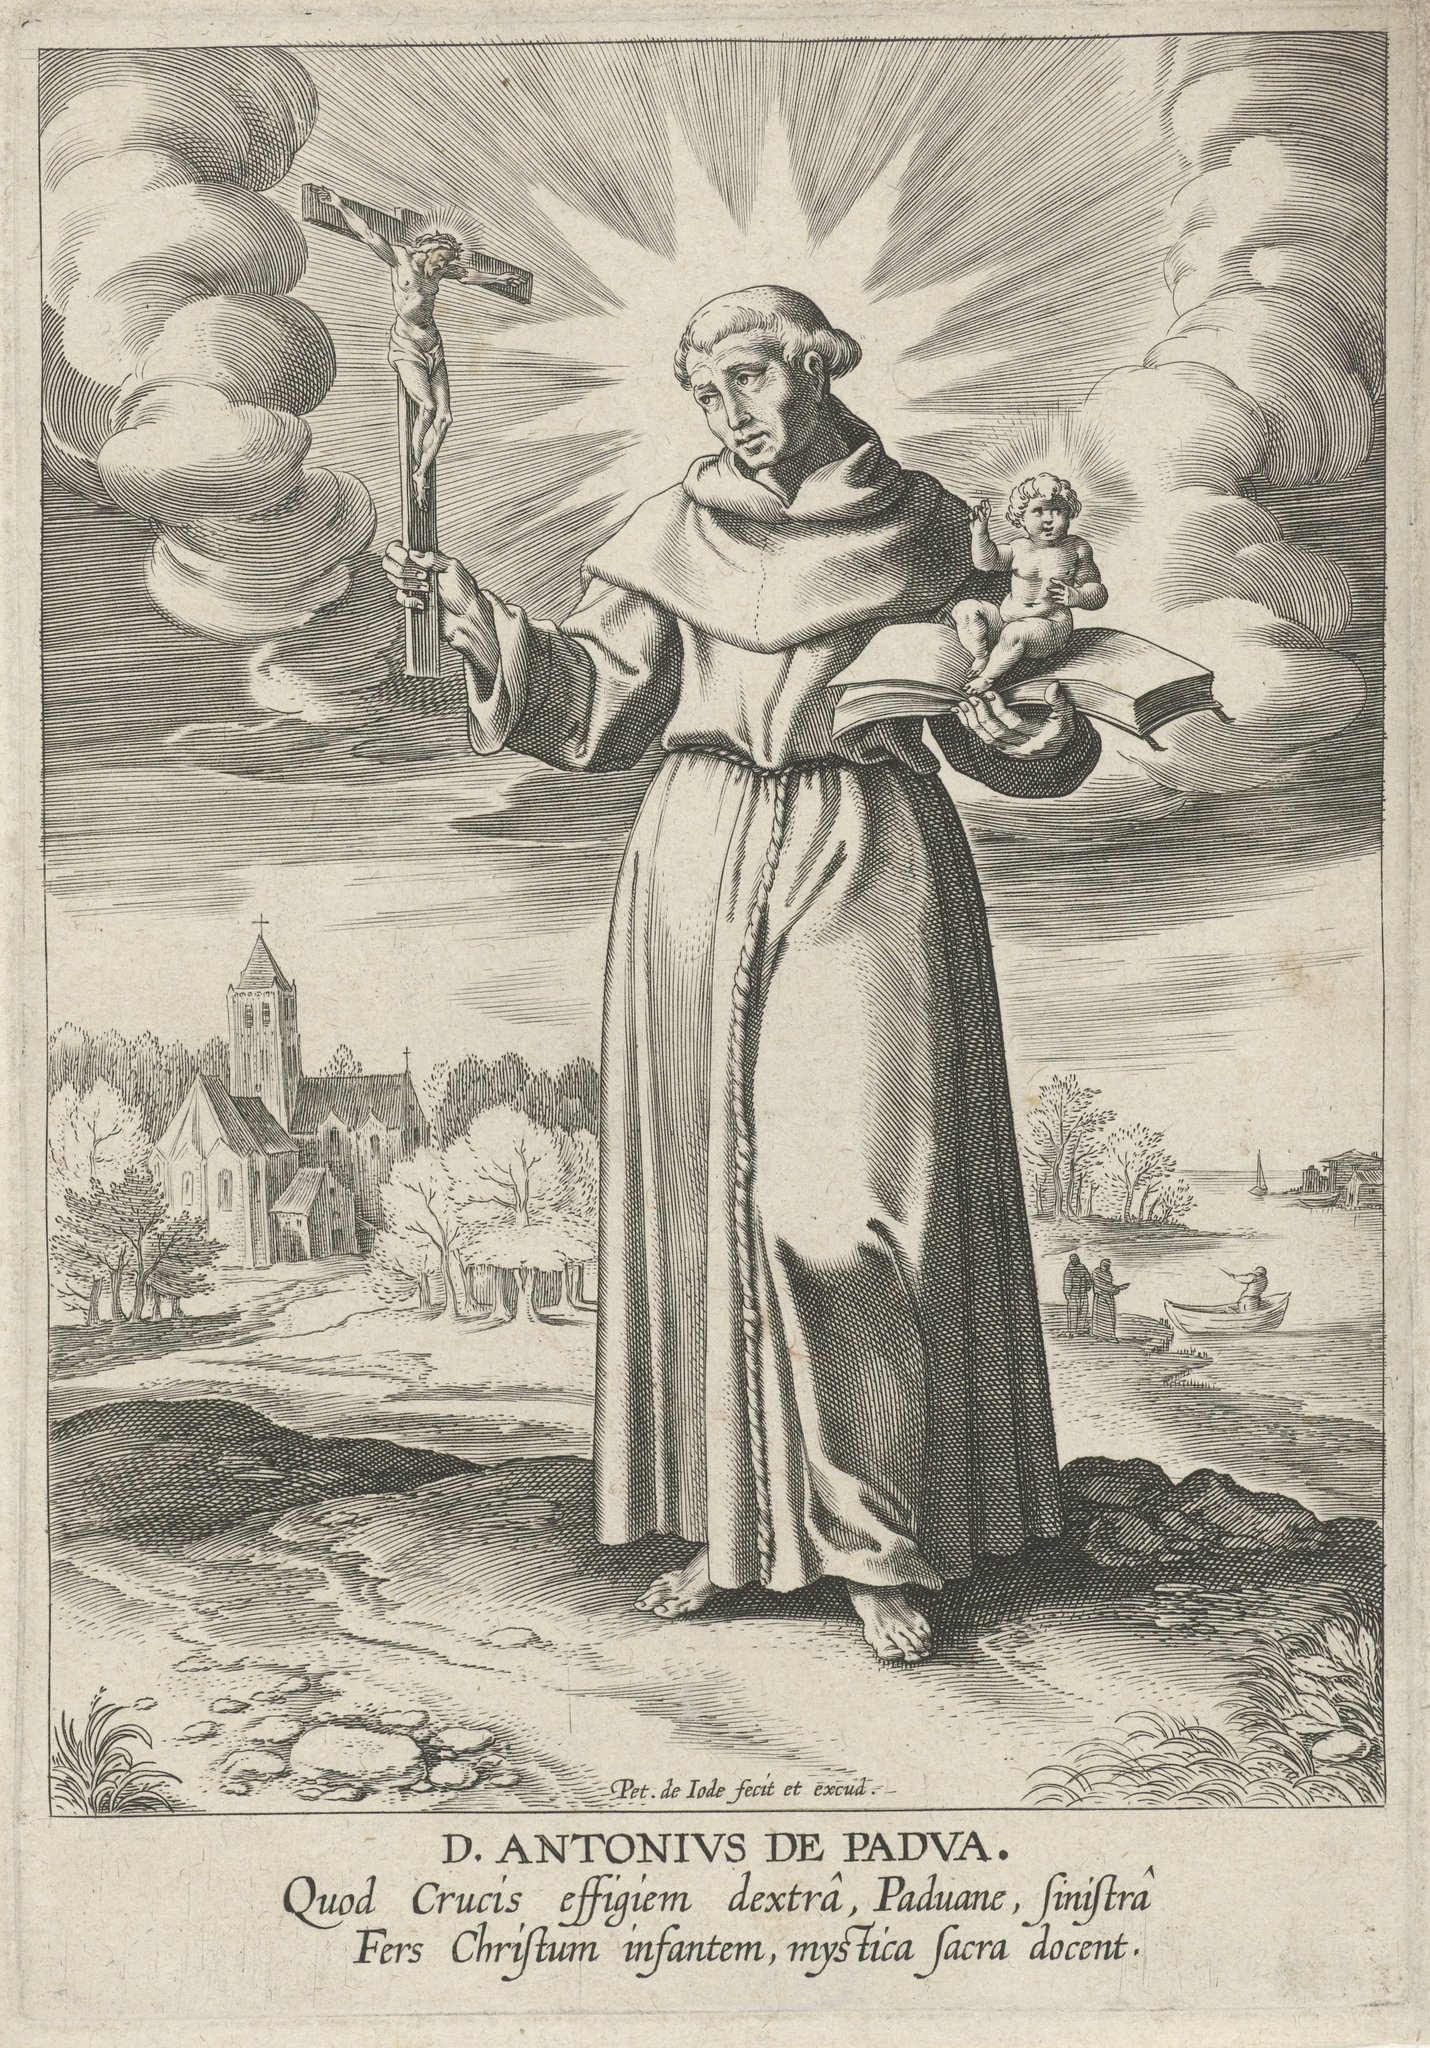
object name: print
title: Landschap met de heilige Antonius van Padua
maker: pieter de jode (i)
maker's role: draughtsman, print maker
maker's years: 1570-1634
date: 1590-1632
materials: paper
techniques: engraving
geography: antwerp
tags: the franciscan monk antony of padua; possible attributes: ass, book, crucifix, flowered cross, flaming heart, infant christ (on book), lily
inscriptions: collector's mark: Lugt 2228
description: Landschap met de heilige Antonius van Padua. In zijn rechterhand houdt hij een crucifix en in zijn linkerhand een opengeslagen boek met daarop het naakte Christuskind. In de marge de naam van de heilige en een tweeregelig onderschrift in het Latijn.